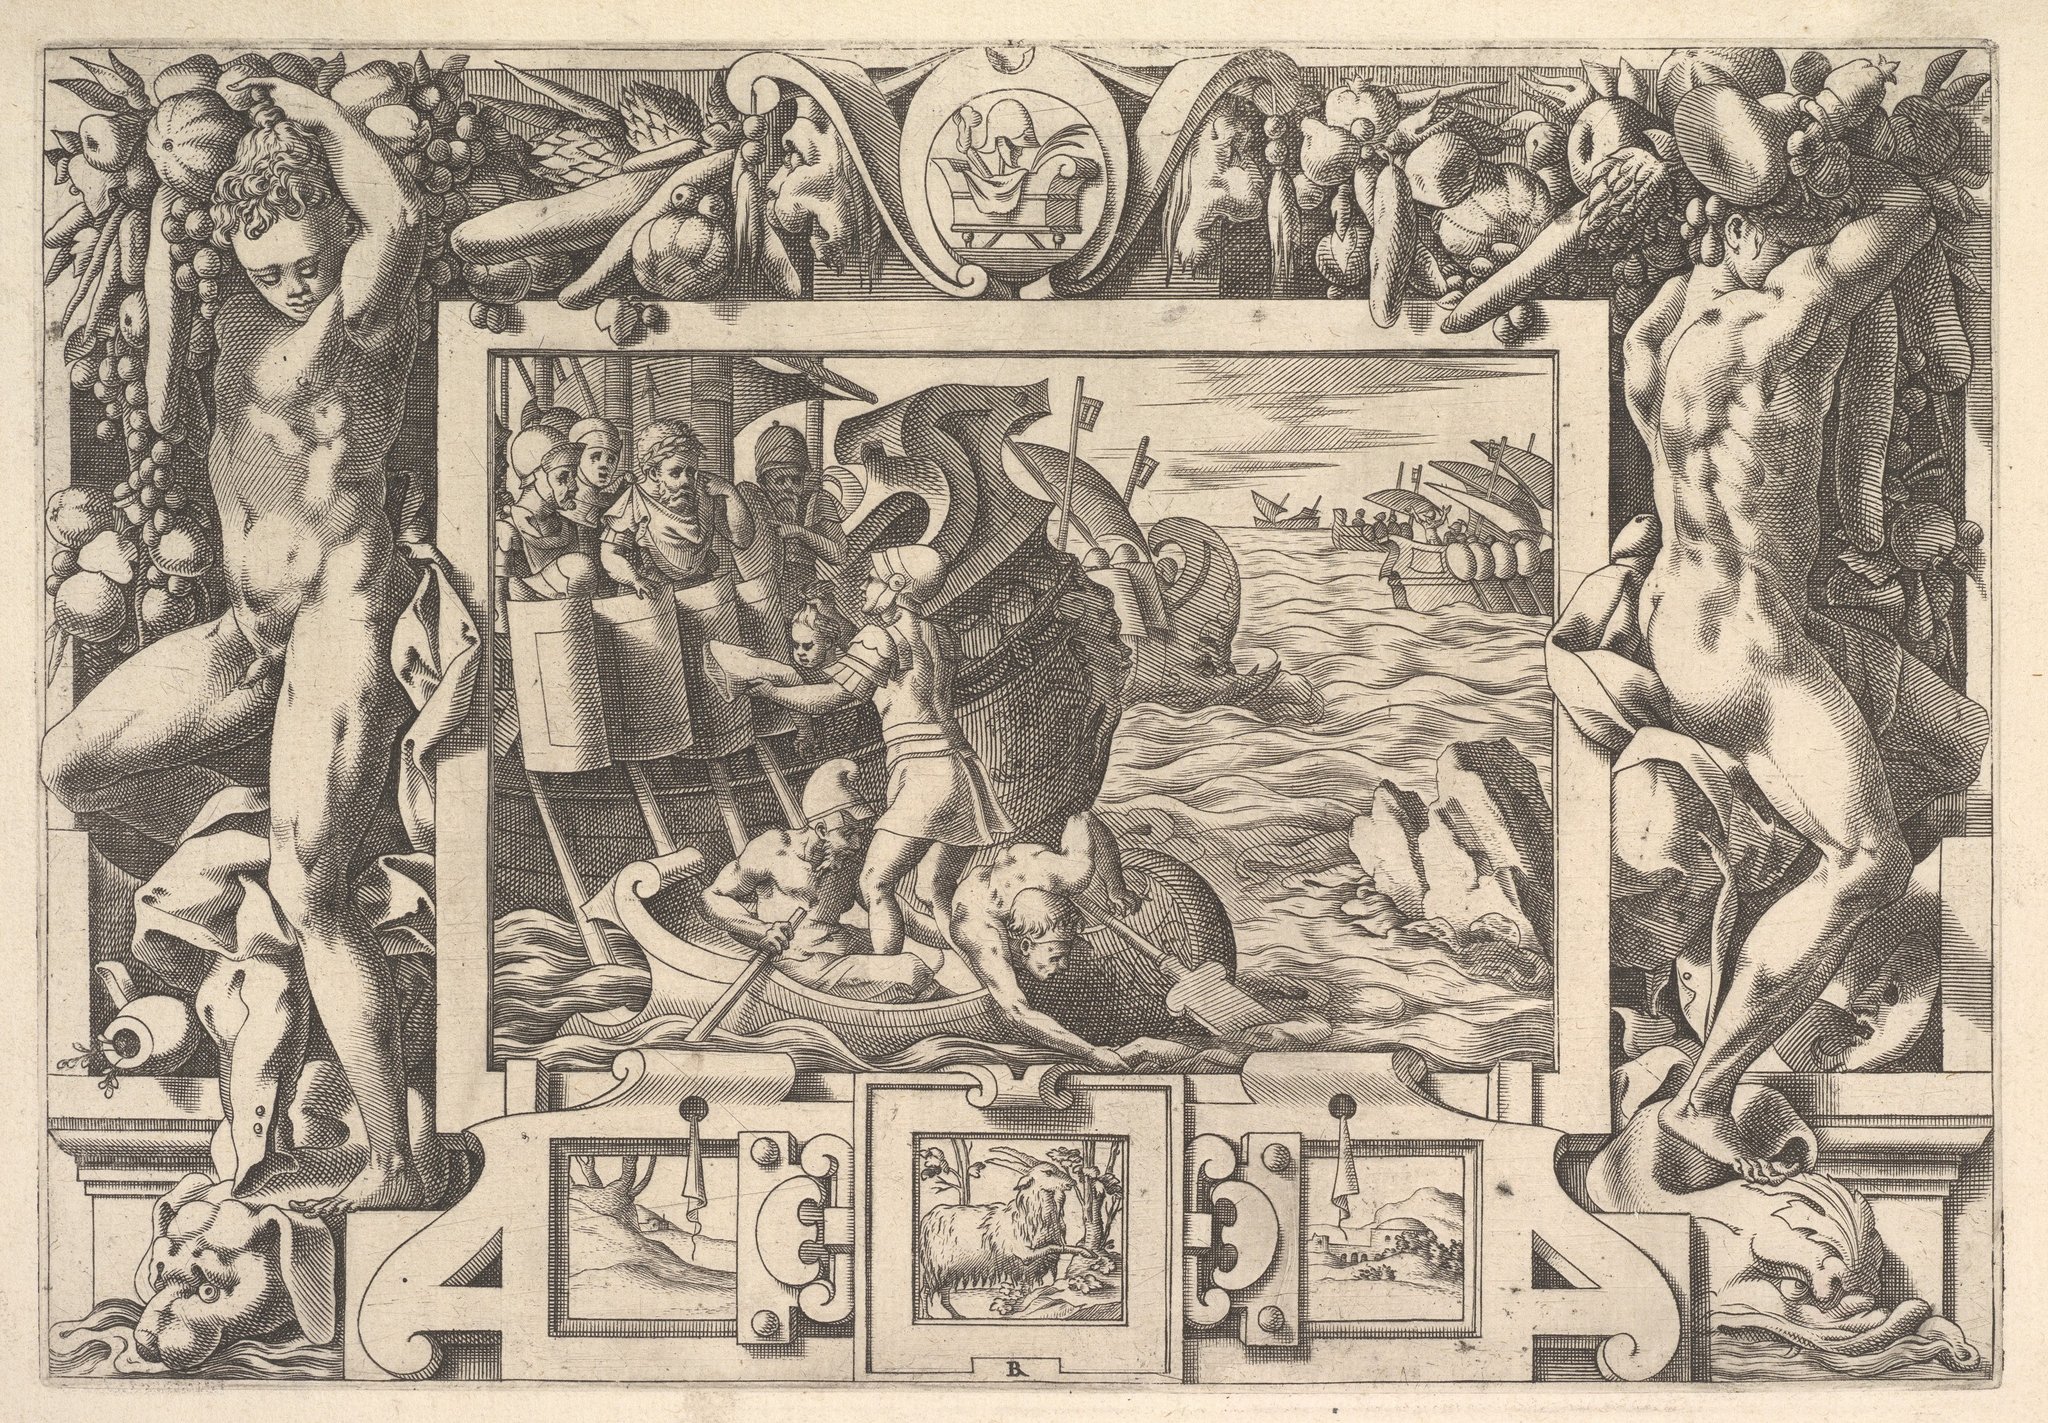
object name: print ornament architecture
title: Aeëtes Gathers the Limbs of Absyrtes (Tandis qu'il fait les membres ramasser, Grecs font devoir de leurs voiles haulser...), from "Jason and the Golden Fleece"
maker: rené boyvin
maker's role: artist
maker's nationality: french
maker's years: 1525-1598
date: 1563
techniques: engraving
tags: men,male nudes,boats,ships